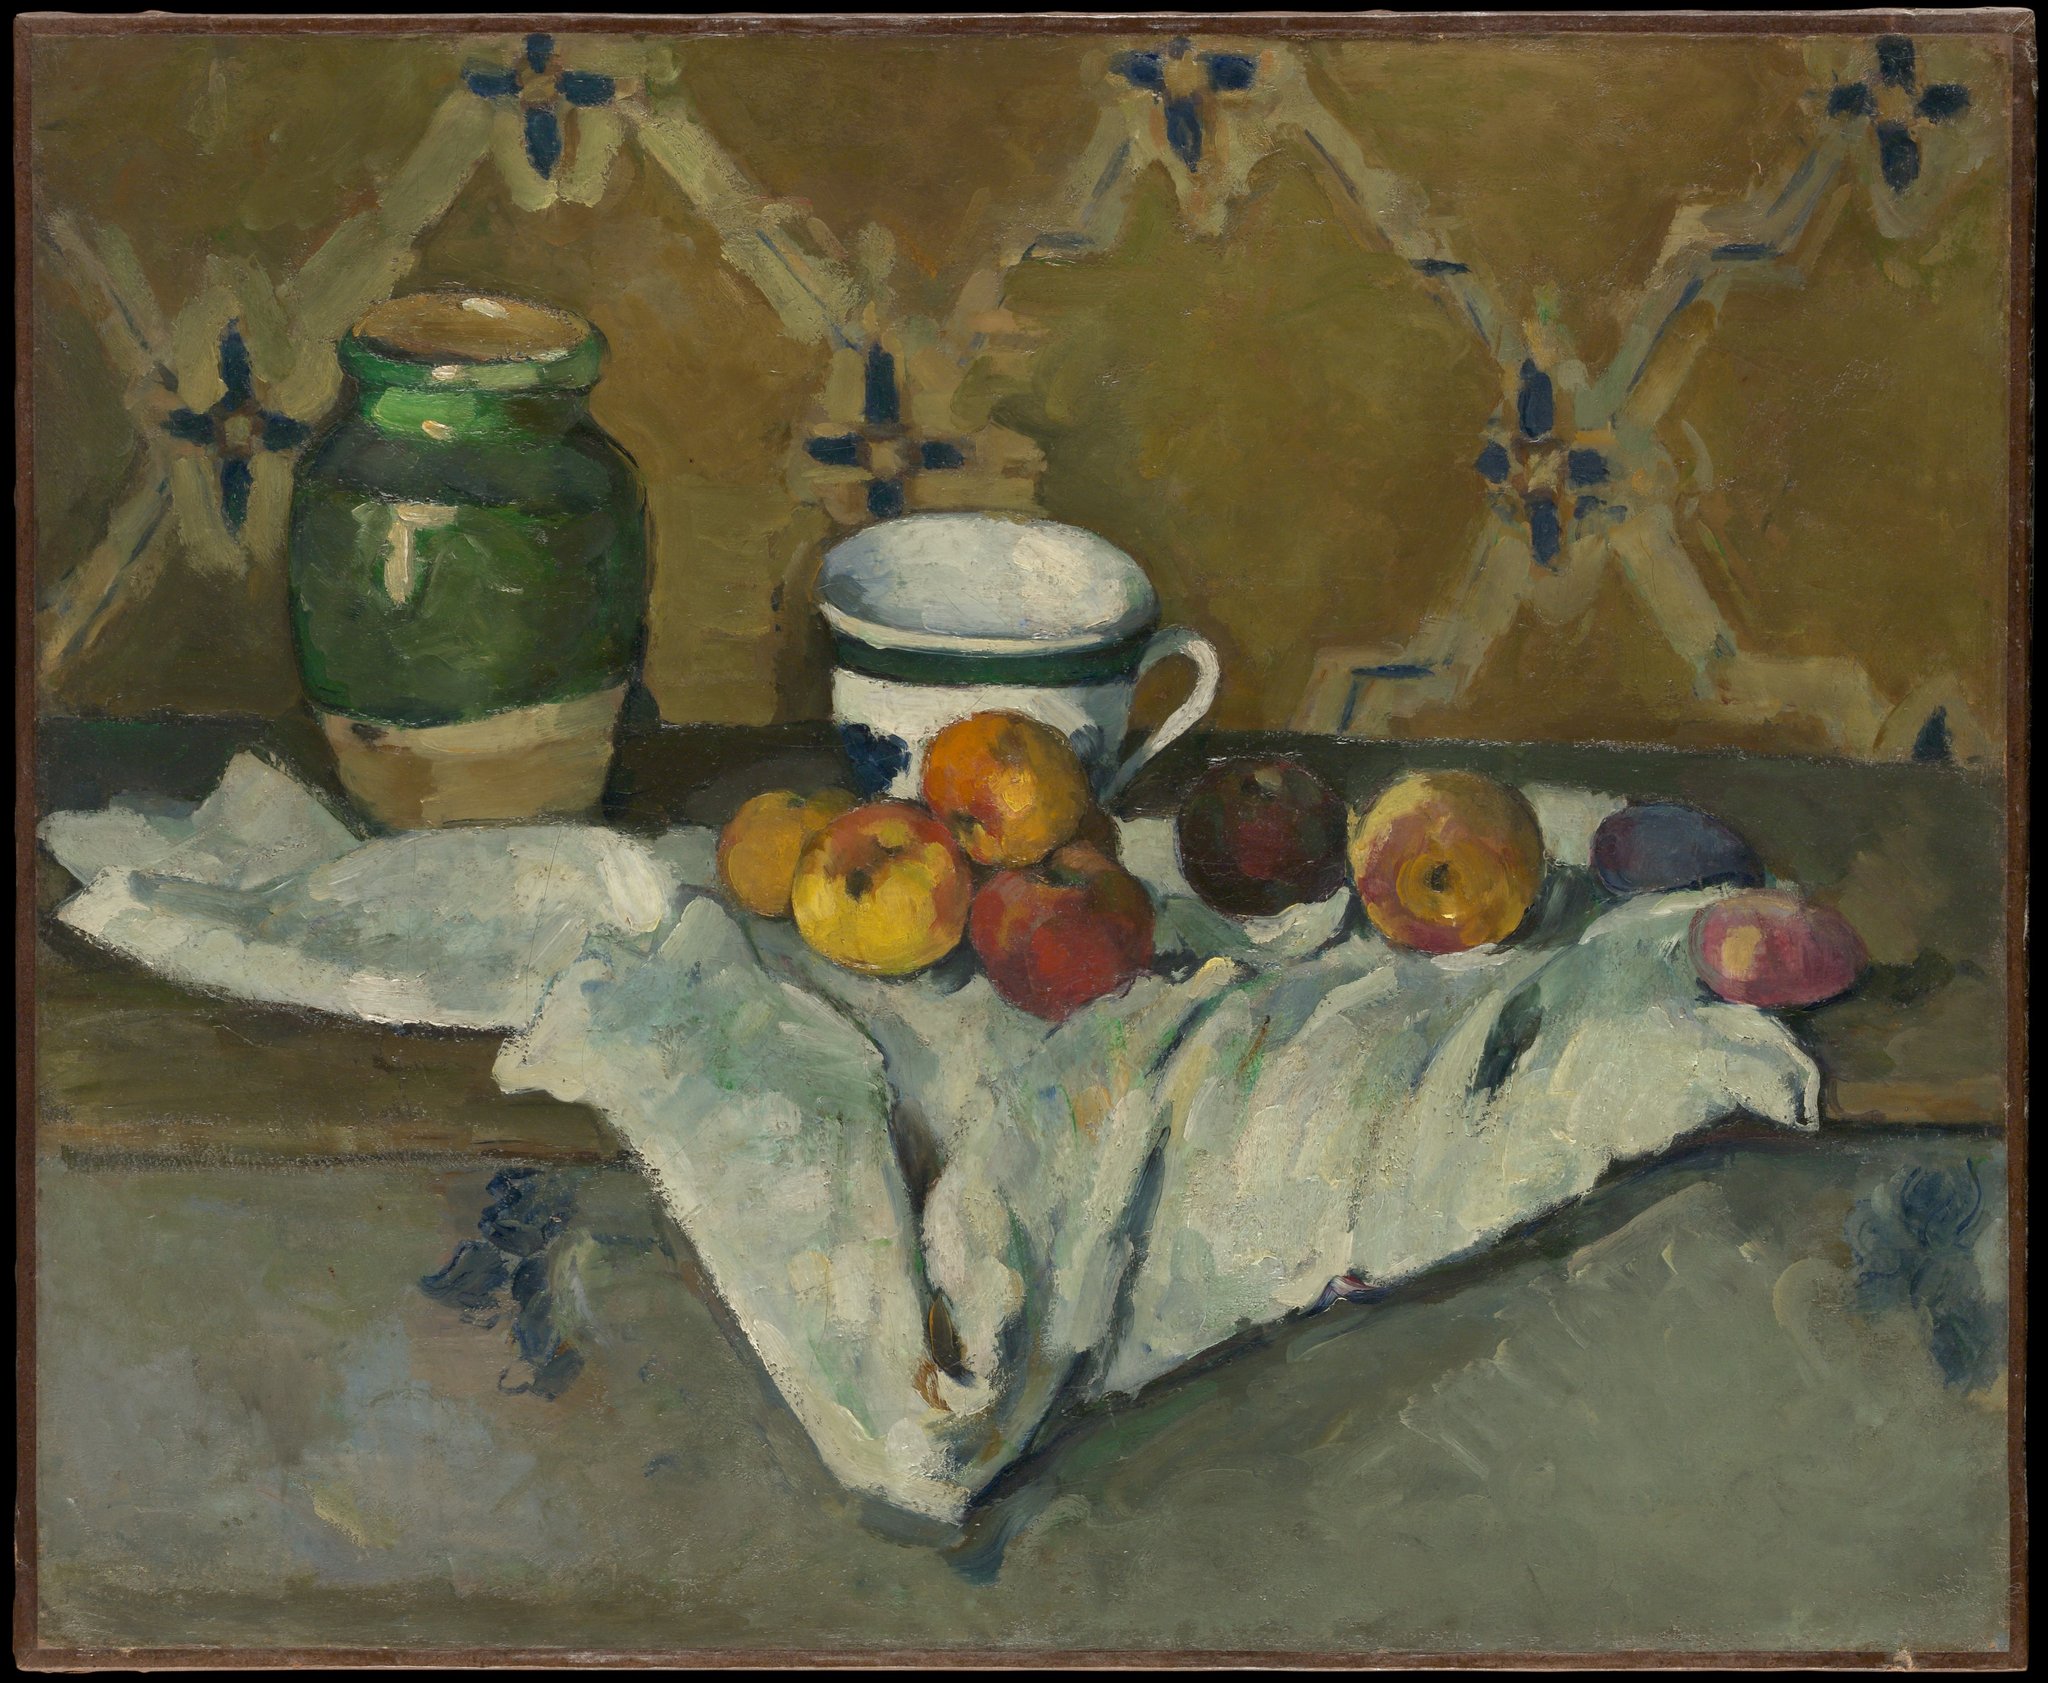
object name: painting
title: Still Life with Jar, Cup, and Apples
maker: paul cézanne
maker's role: artist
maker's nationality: french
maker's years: 1839-1906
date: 1877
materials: canvas, oil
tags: apples,still life,cups,jars